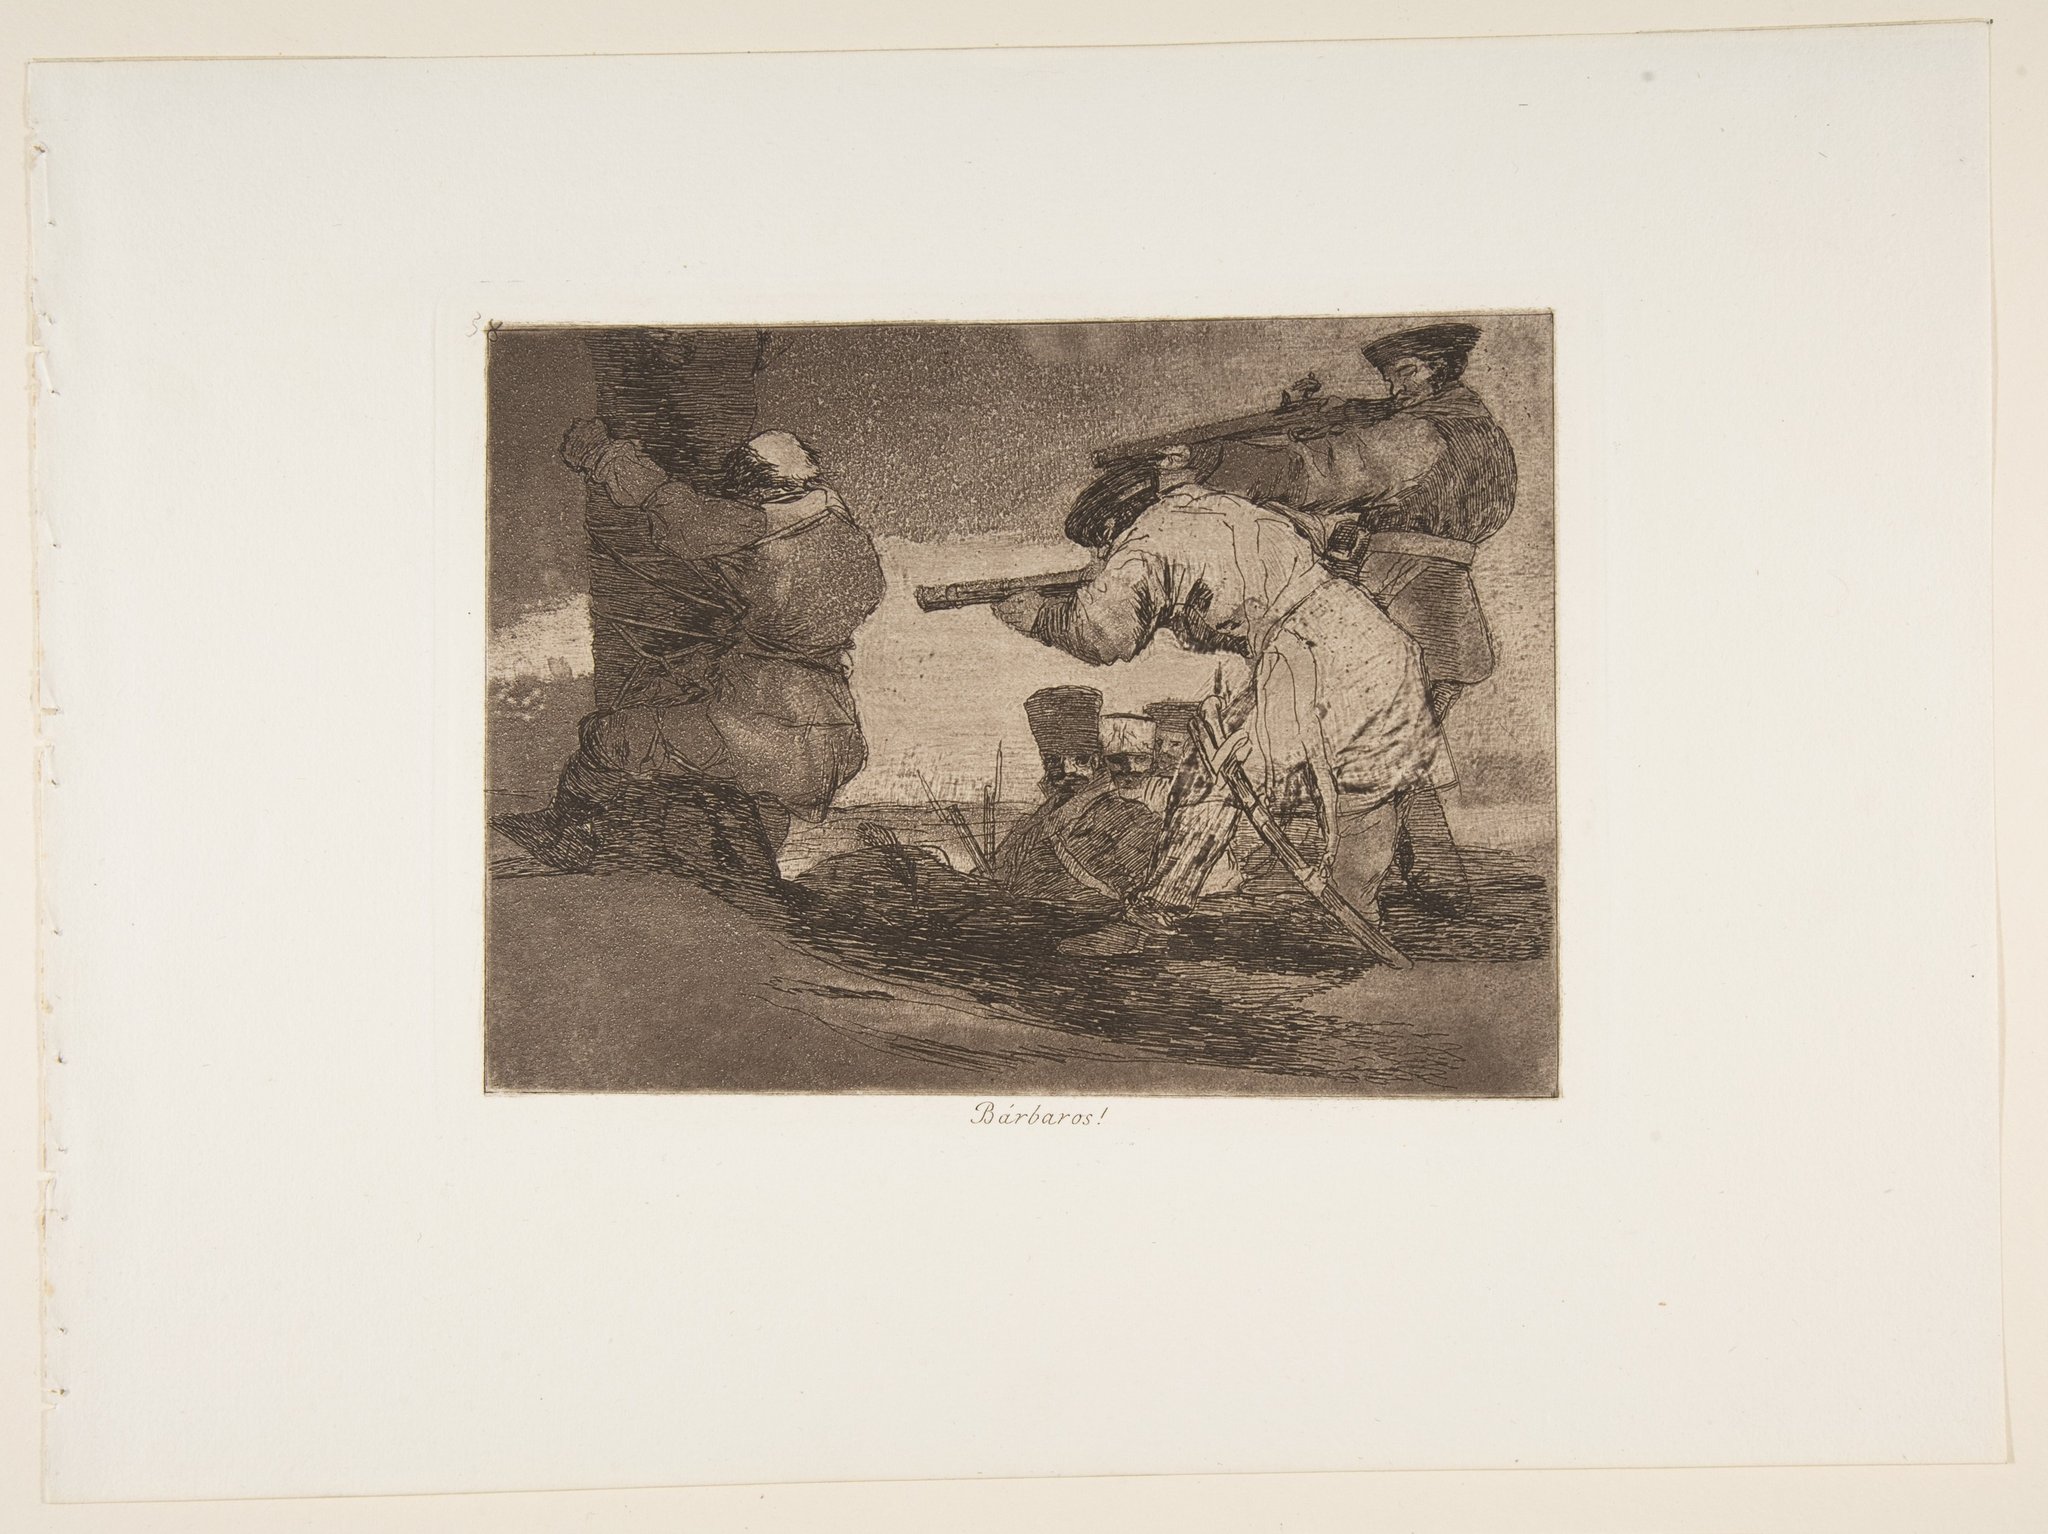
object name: print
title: Plate 38 from "The Disasters of War" (Los Desastres de La Guerra): 'Barbarians!' (Bárbaros!)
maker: goya (francisco de goya y lucientes)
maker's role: artist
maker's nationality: spanish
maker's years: 1746-1828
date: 1810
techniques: aquatint, engraving, burnishing, etching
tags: soldiers,weapons,men